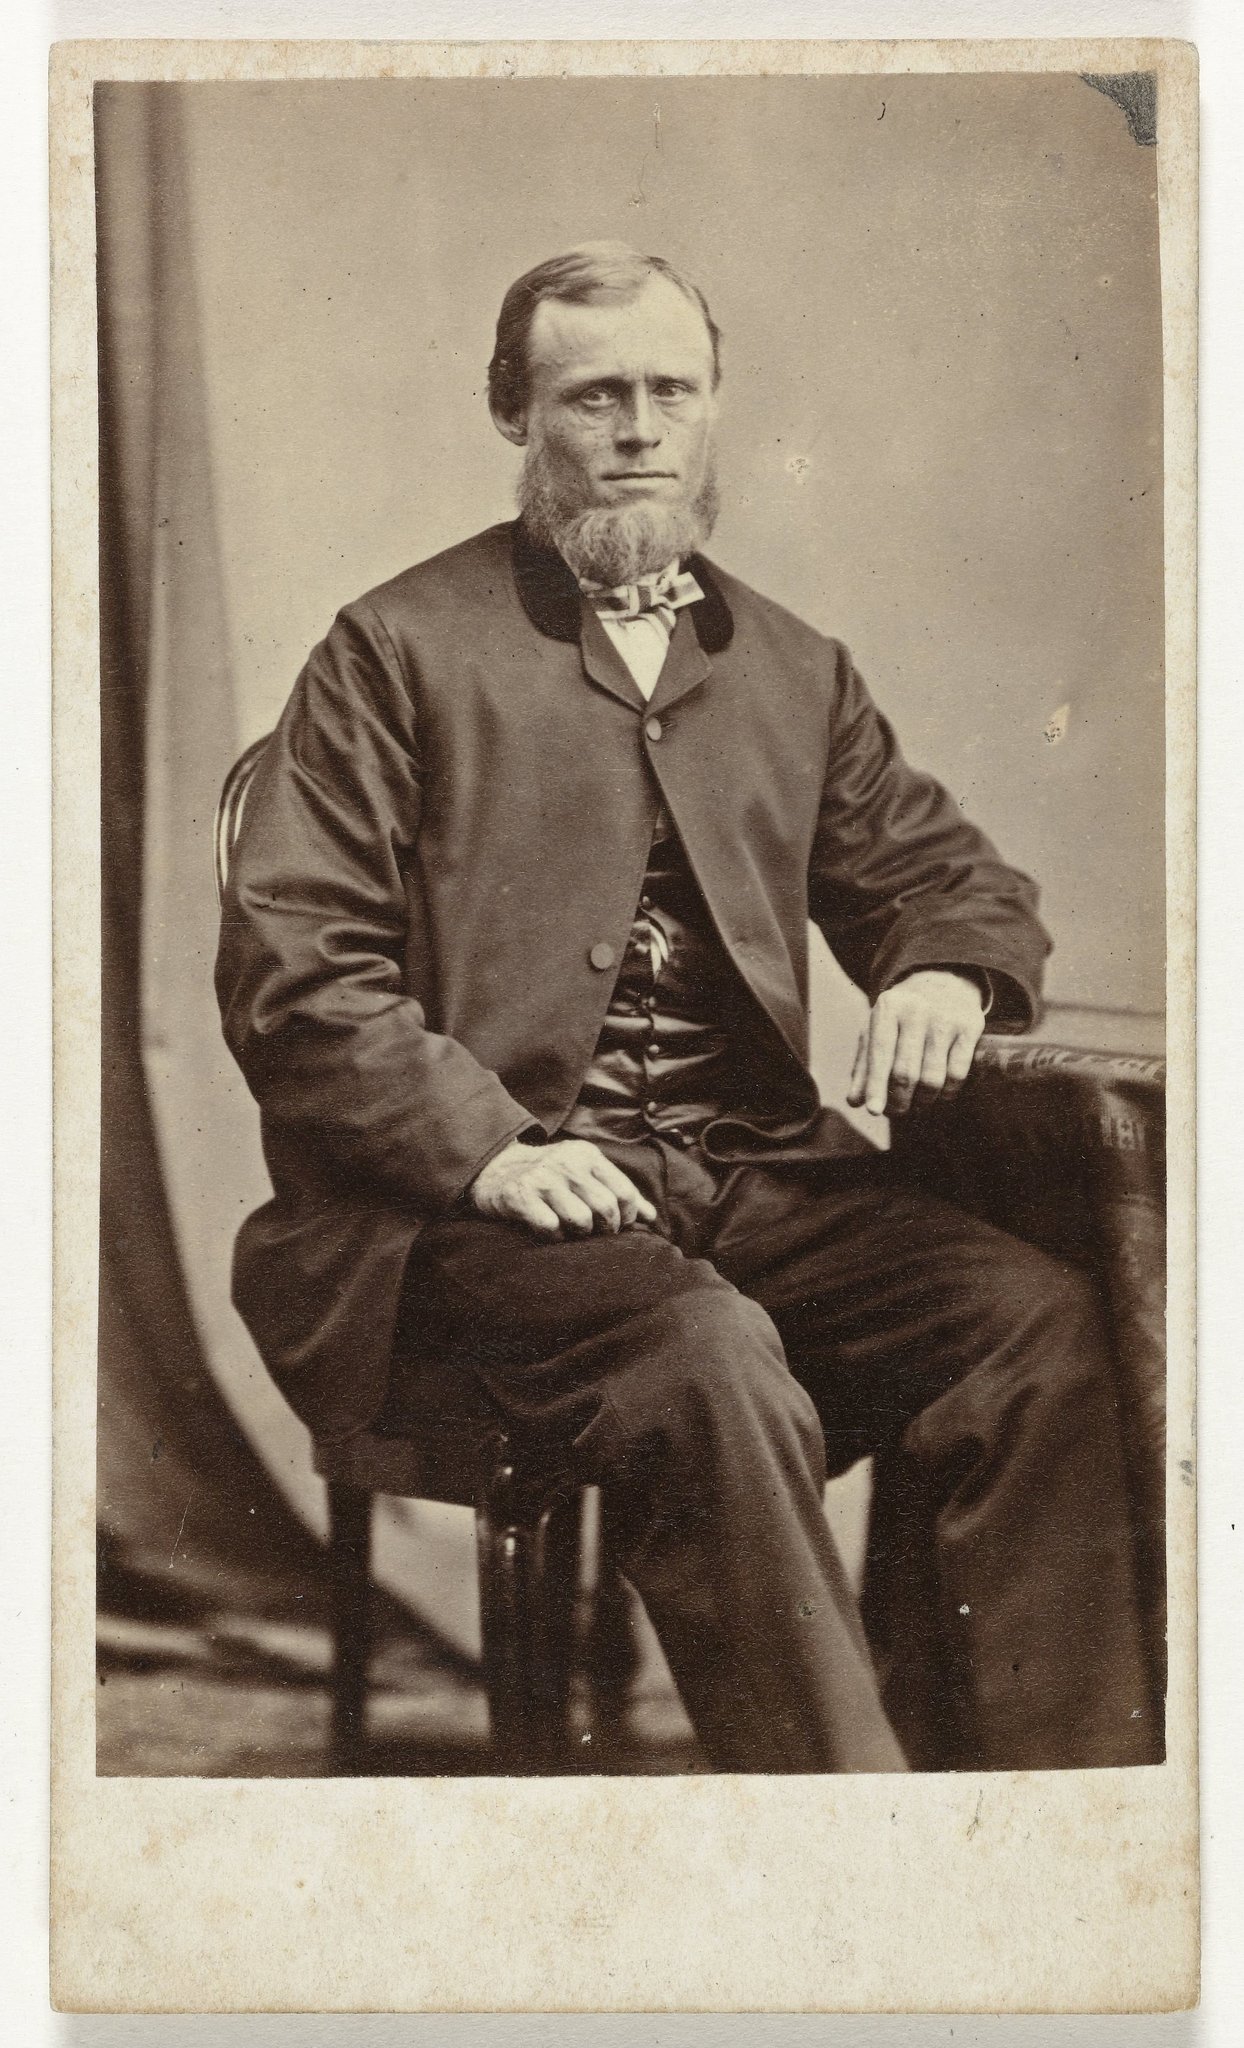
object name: photograph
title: Portret van een man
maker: hermanus philippus jacobus schuiten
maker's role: fotograaf, lijstenmaker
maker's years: 1820-1869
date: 1864-1868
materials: cardboard, paper, photographic support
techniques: albumen print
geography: amsterdam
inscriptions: address: ‘Atelier de Photographie/H.PH.J. Schuiten/Amsterdam’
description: Man met een baard, zittend naast een tafel. Linksachter een gordijn